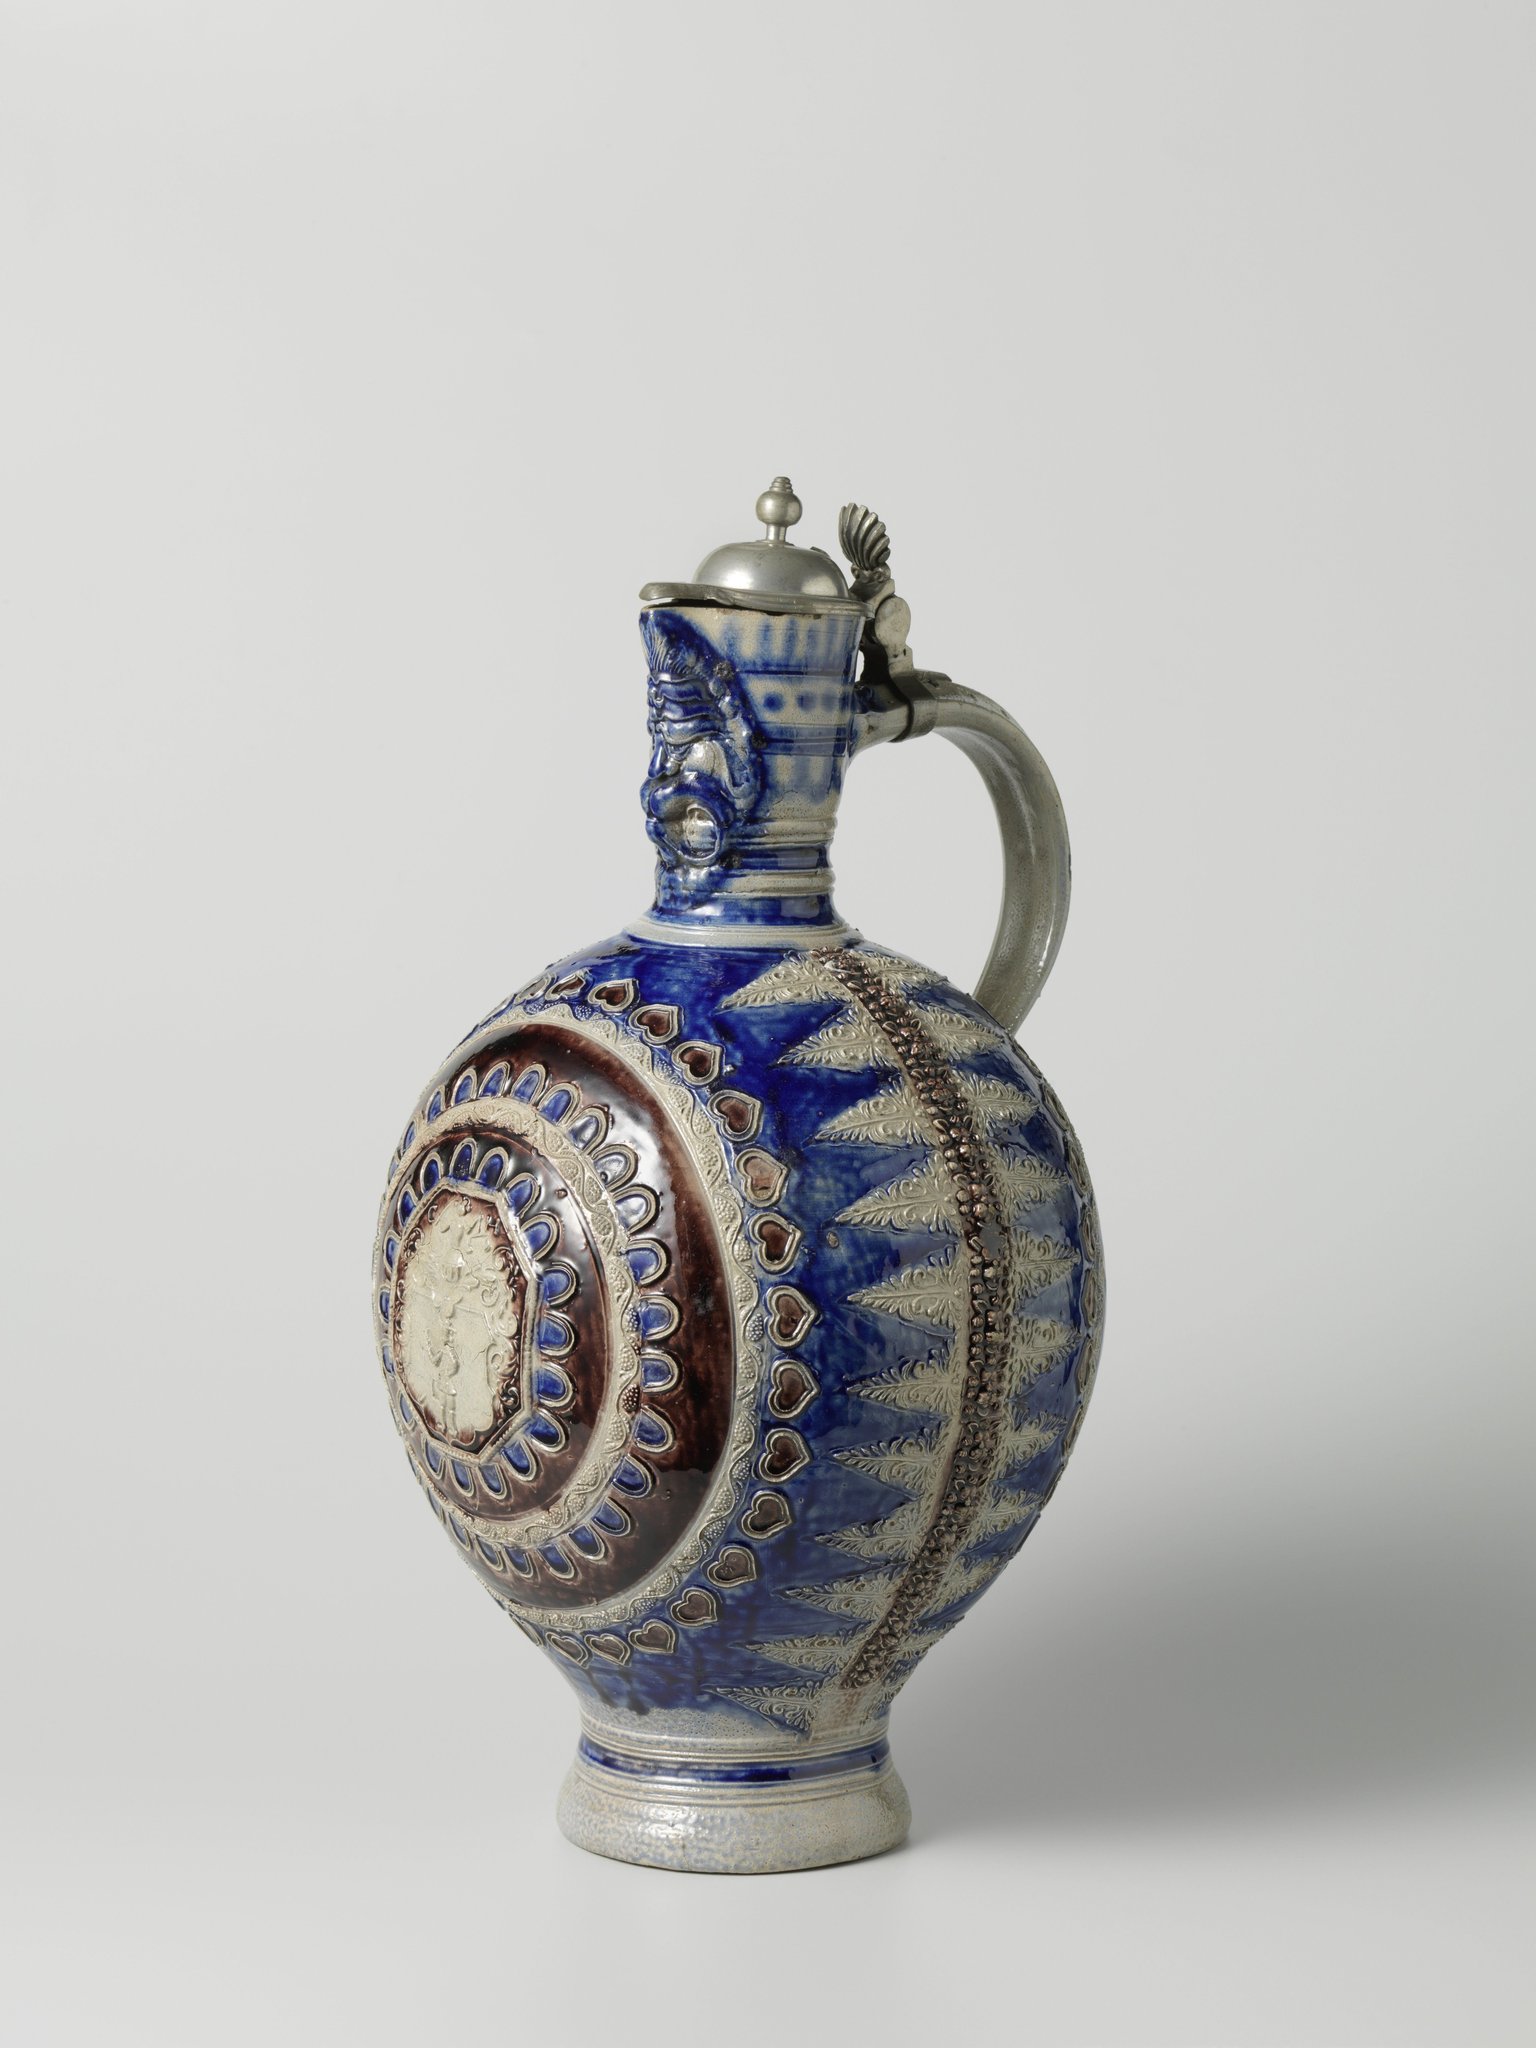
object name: ewer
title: Jug with a coat of arms among concentric circles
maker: Anonymous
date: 1650-1670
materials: cobalt, glaze, mineral, stoneware, tin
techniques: printing, firing, forming, relief, turning, vitrification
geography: westerwald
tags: lion's head ~ ornament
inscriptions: mark: ‘C.H.’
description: Kan van steengoed op hoge voet met een bolvormig lichaam en smalle nek met een geknepen tuit. Het C-vormige oor is bevestigd aan de nek en de schouder. Profielen op de nek en de voet. Gedeeltelijk bedekt met kobaltblauw en mangaanpaars. Op de voorzijde van de buik een medaillon gevormd door concentrische cirkels van gedrukte en opgelegde halve cirkel, hartvormen en druivenranken. In het centrum een achthoek met een wapen met een staande man, waarin het merk 'C.H.' aan weerszijden van het helmteken in de vorm van Vrouwe Justicia. Om het oor een grote, gestempelde rozet uitgespaard in blauw binnen een cirkel van hartvormen en druivenranken. De zijkanten met een verticale band maskers met aan weerszijden puntige bladmotieven. Op de nek een gemodelleerd masker. Bevestigd aan het oor een tinnen montuur met deksel. Westerwald.